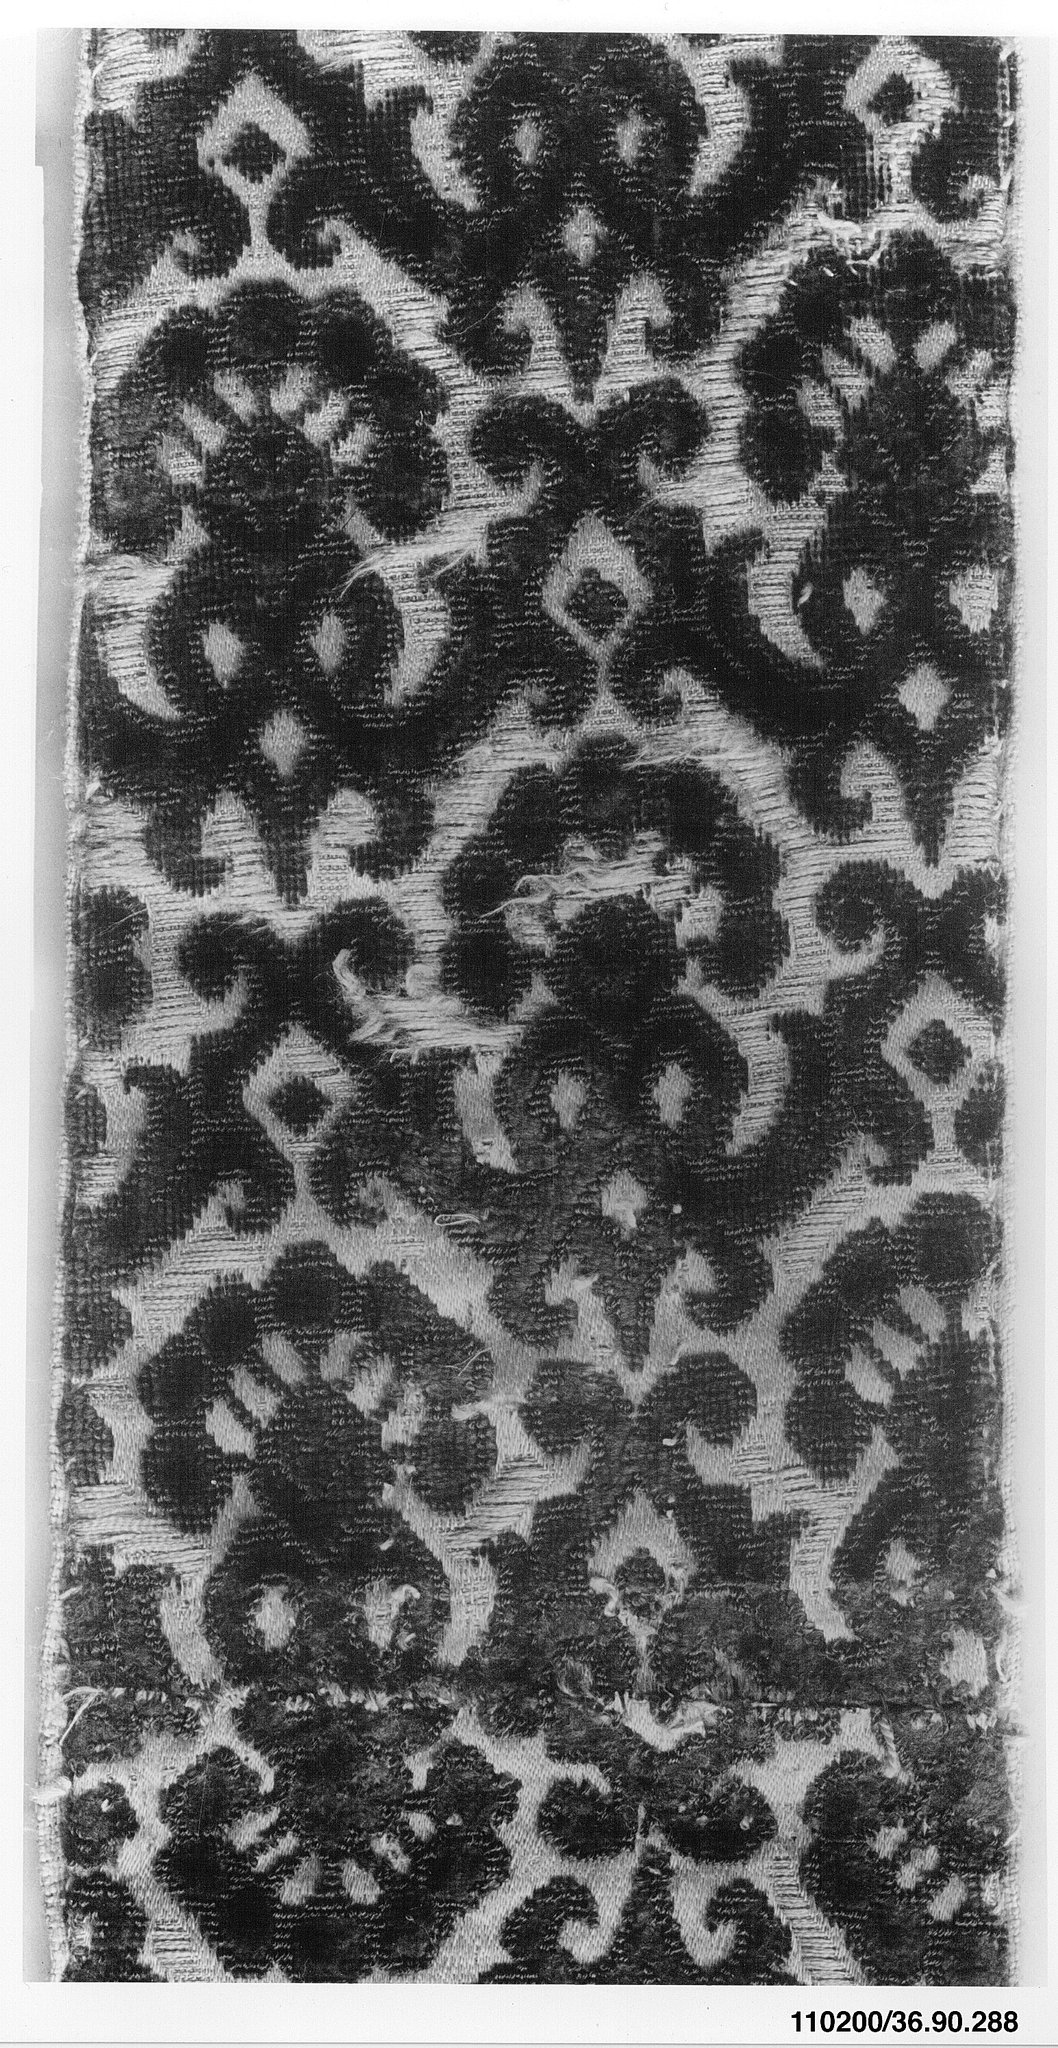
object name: piece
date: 1501-1700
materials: silk